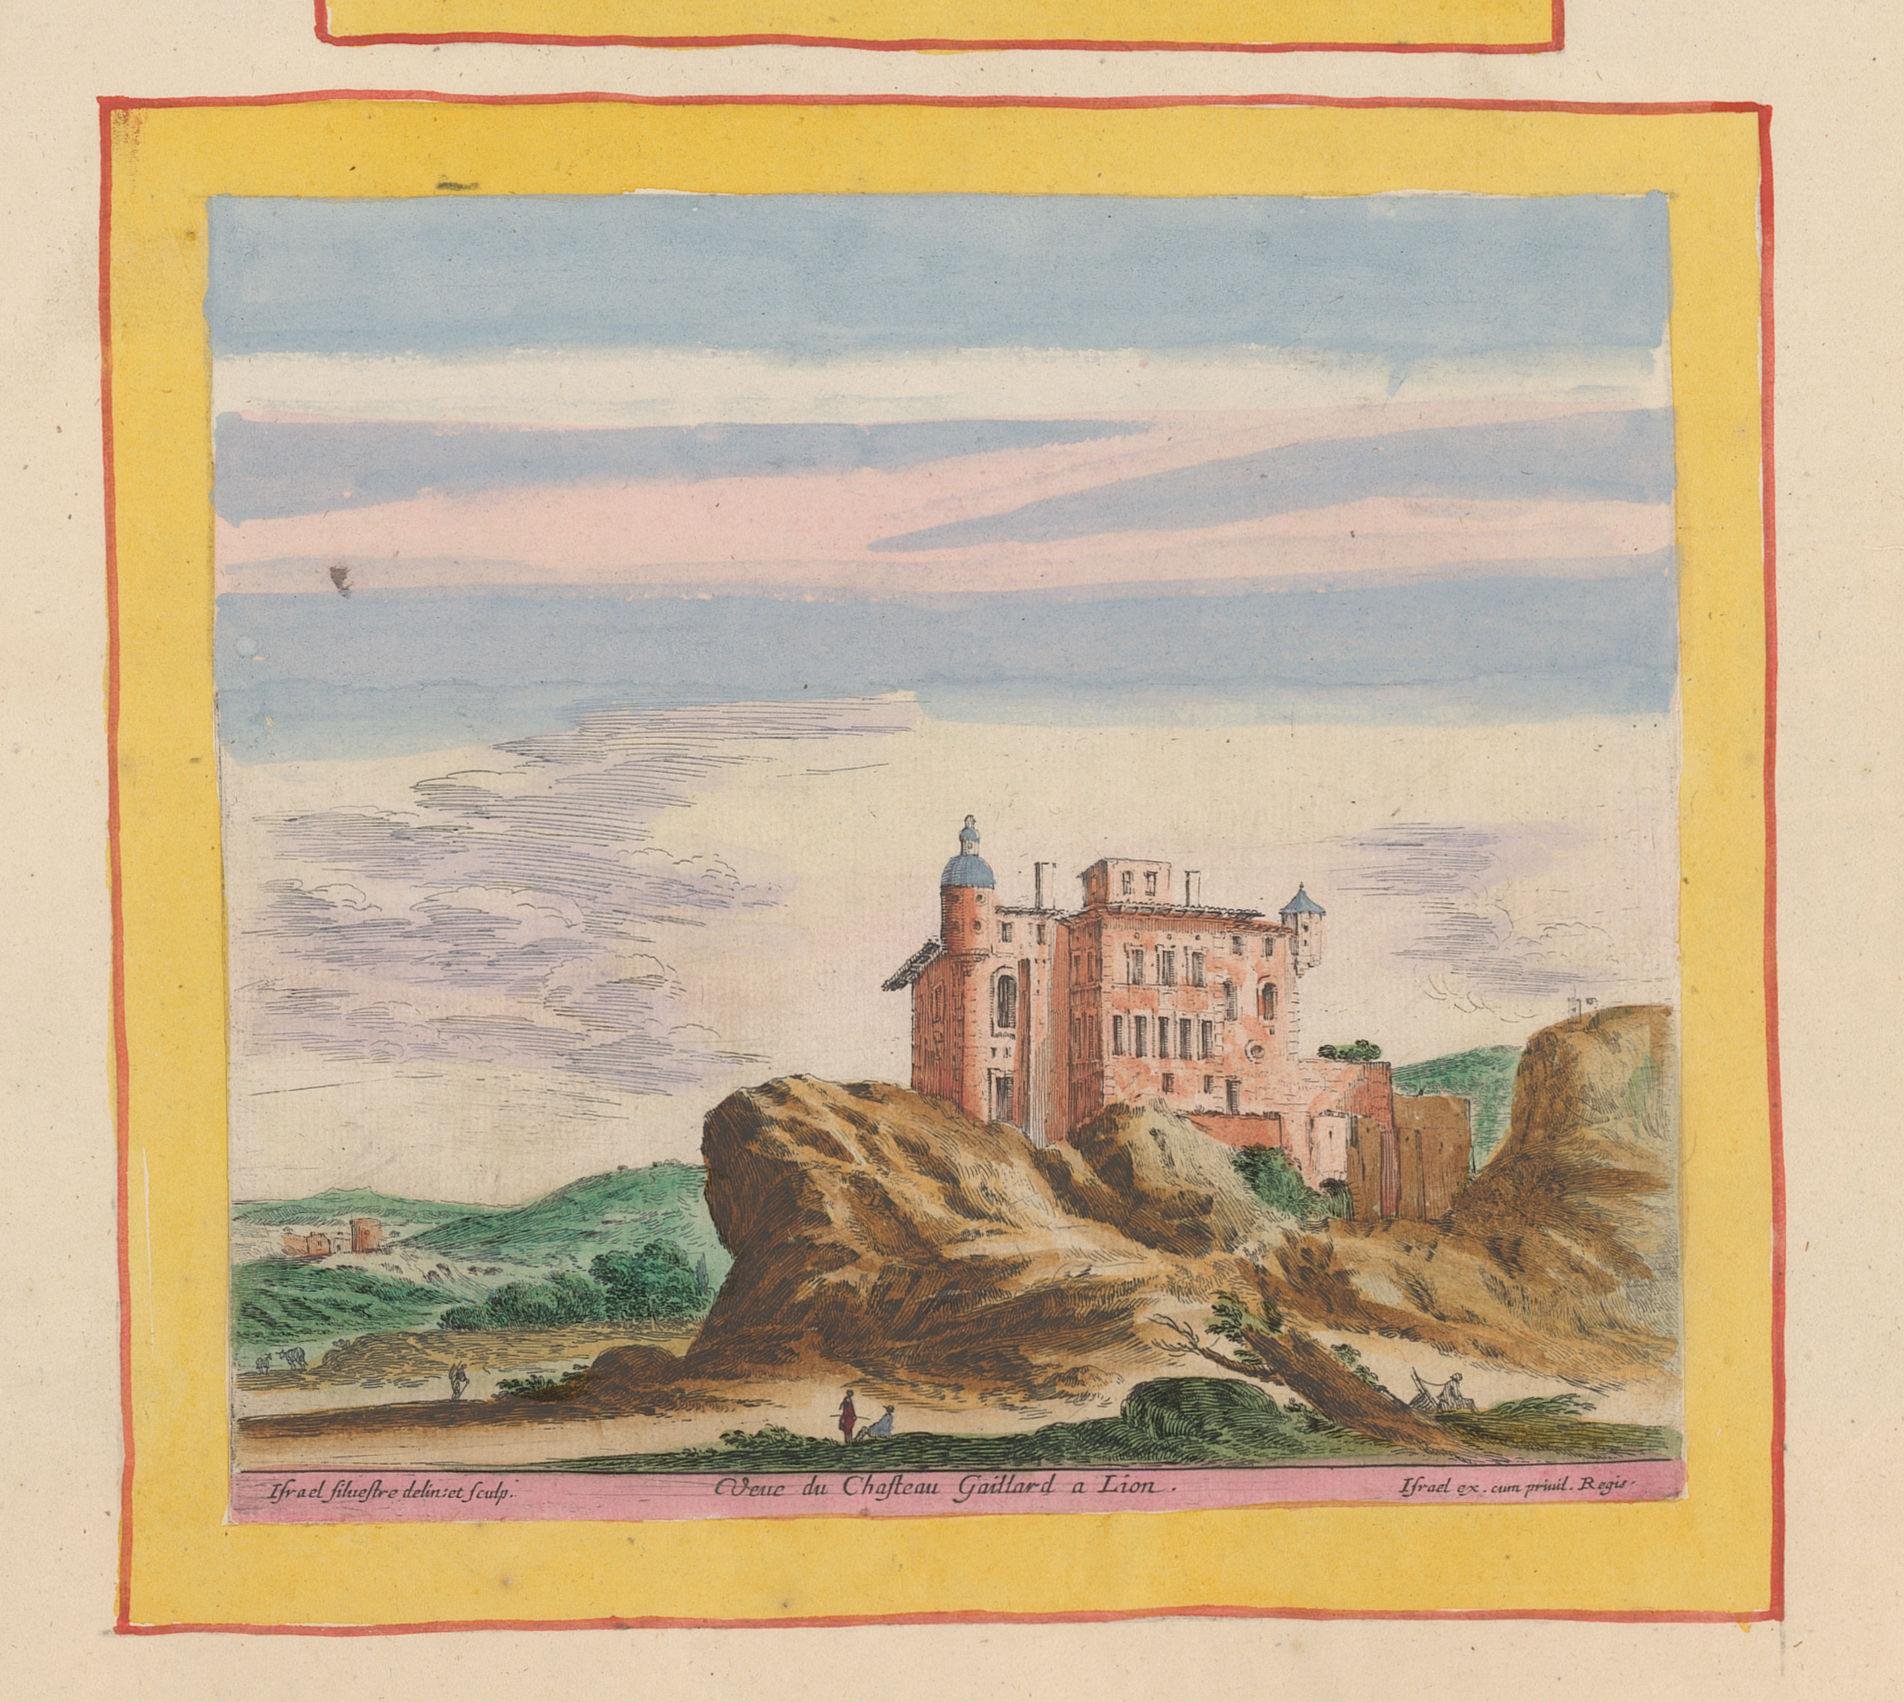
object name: print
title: Diverse stadsgezichten gemaakt door Israël Silvestre in 1652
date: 1652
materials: paper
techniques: etching, hand coloring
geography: paris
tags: city-view in general; 'veduta', castle, lyon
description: Deze prent maakt deel uit van een album.